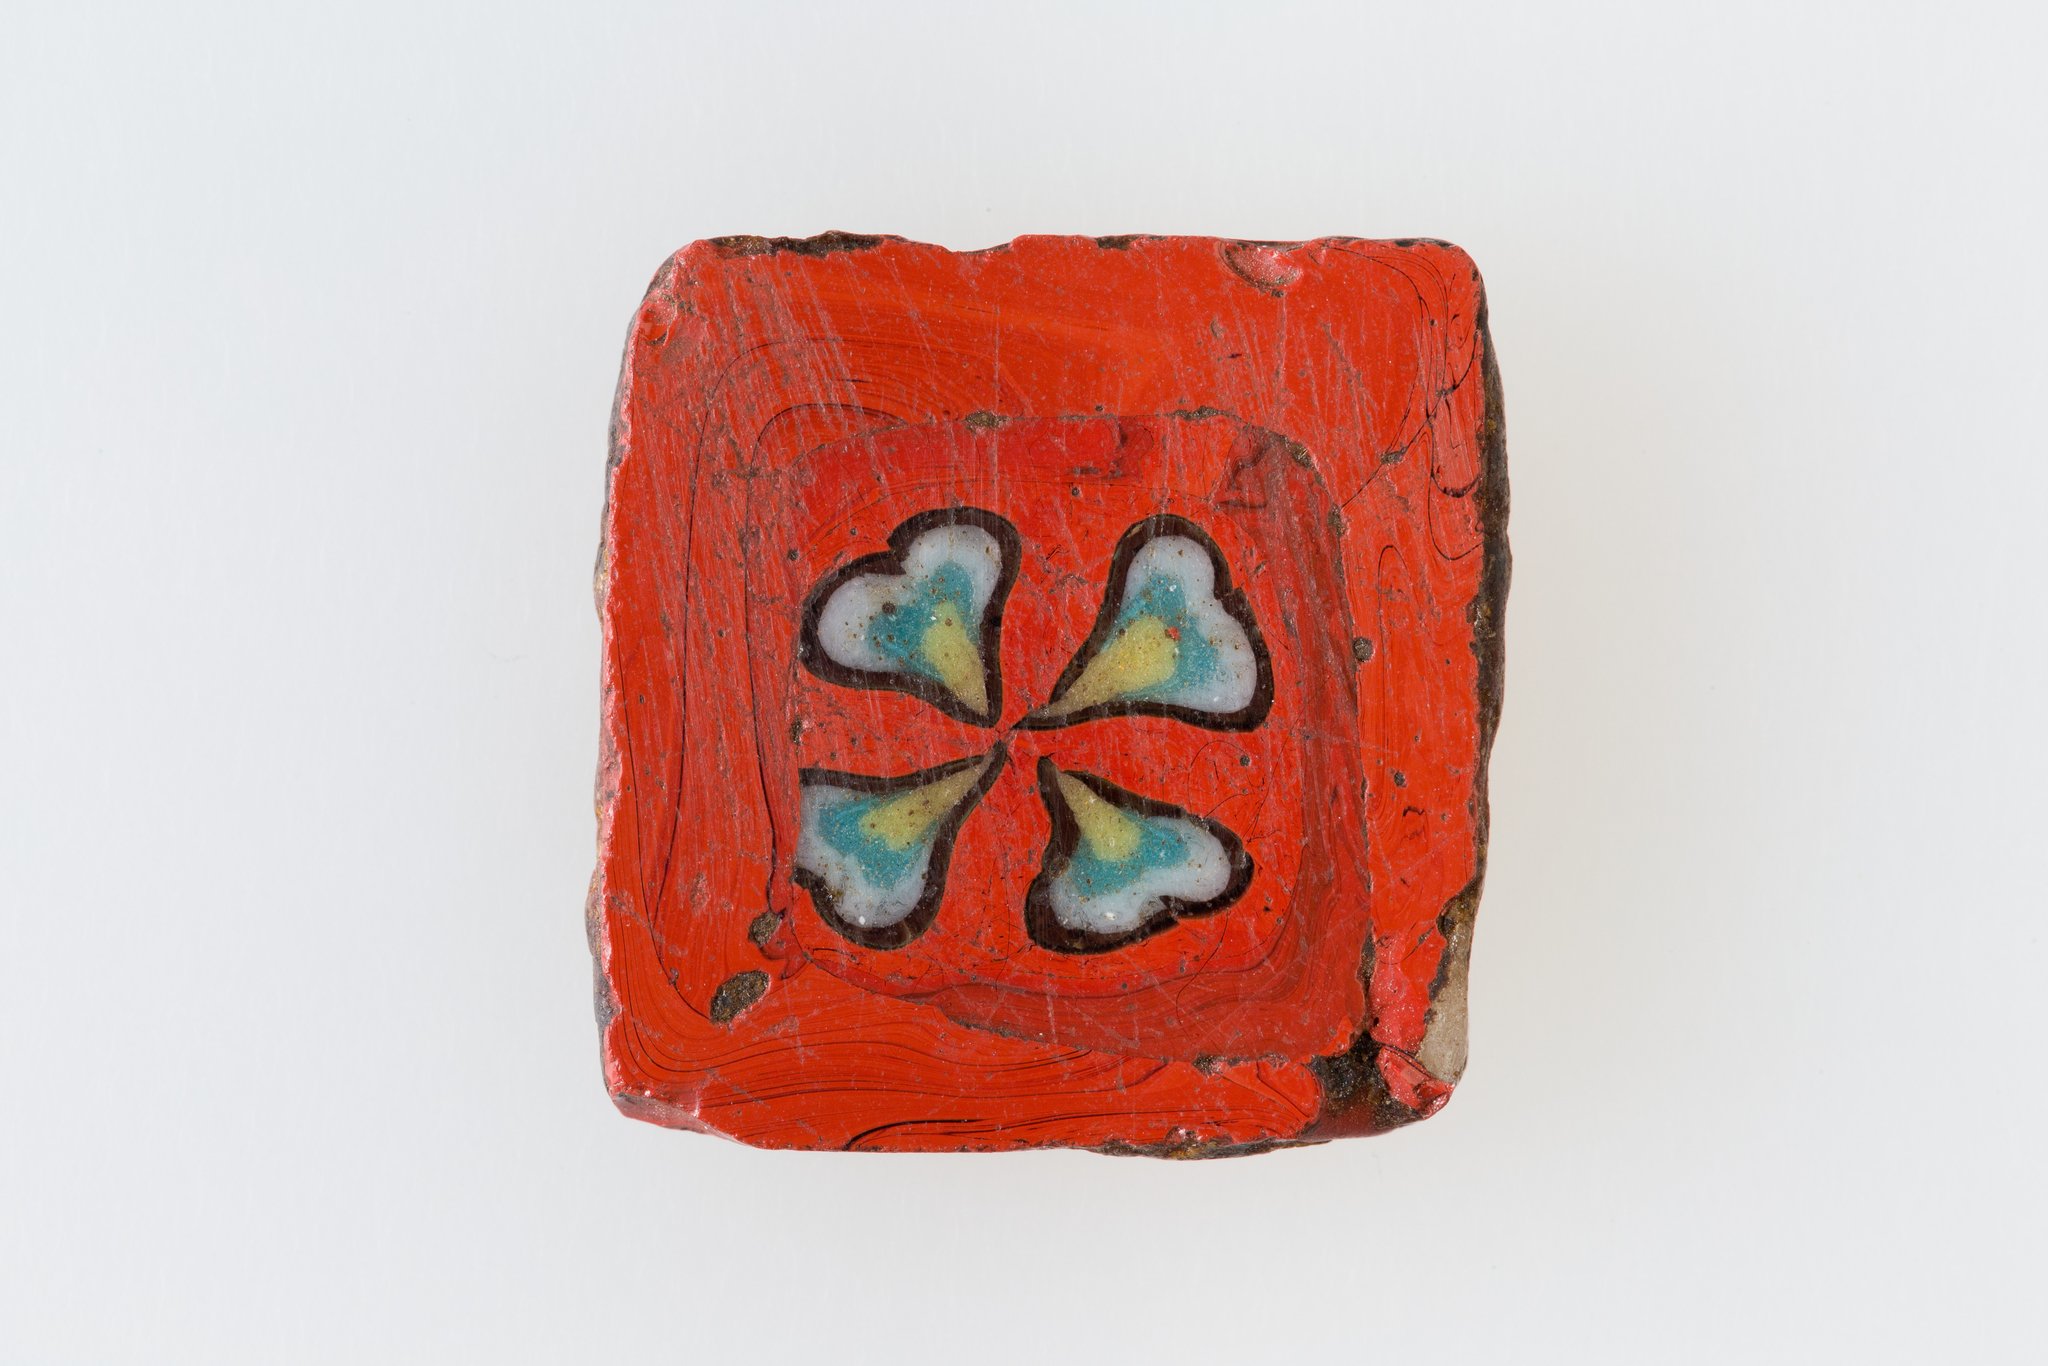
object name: inlay, square, floral design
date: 1-300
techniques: mosaic glass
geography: egypt